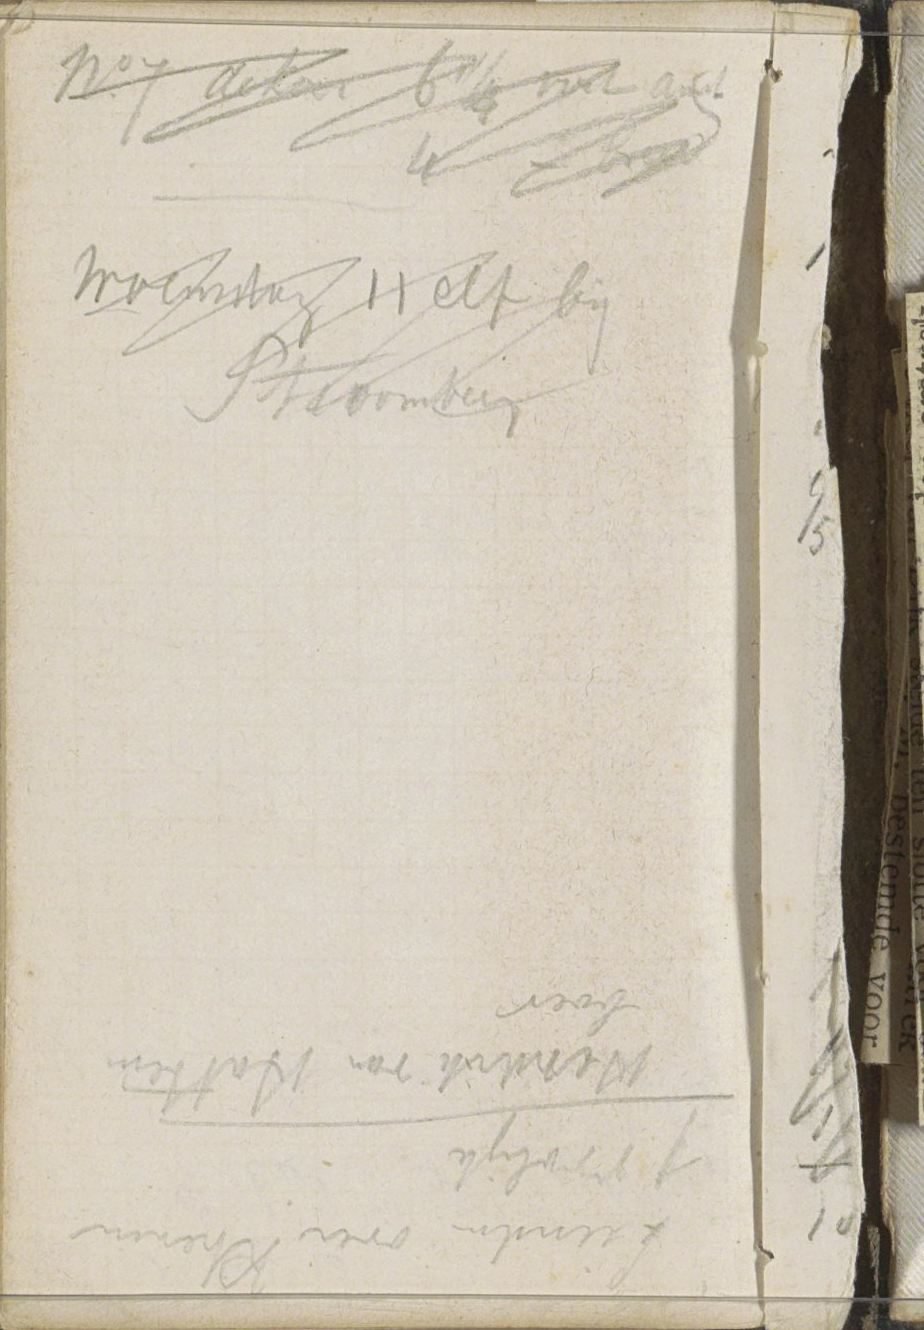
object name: sketchbook leaf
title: Notities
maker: jan willem van borselen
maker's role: draughtsman, print maker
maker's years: 1825-1892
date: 1868-1887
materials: pencil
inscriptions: annotation: ‘[...]ienden over Rhenen/ J Vrolijk/ Hendrik van Hattem/ boer/ [...]’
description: Blad 51 verso uit een schetsboek met 51 bladen.